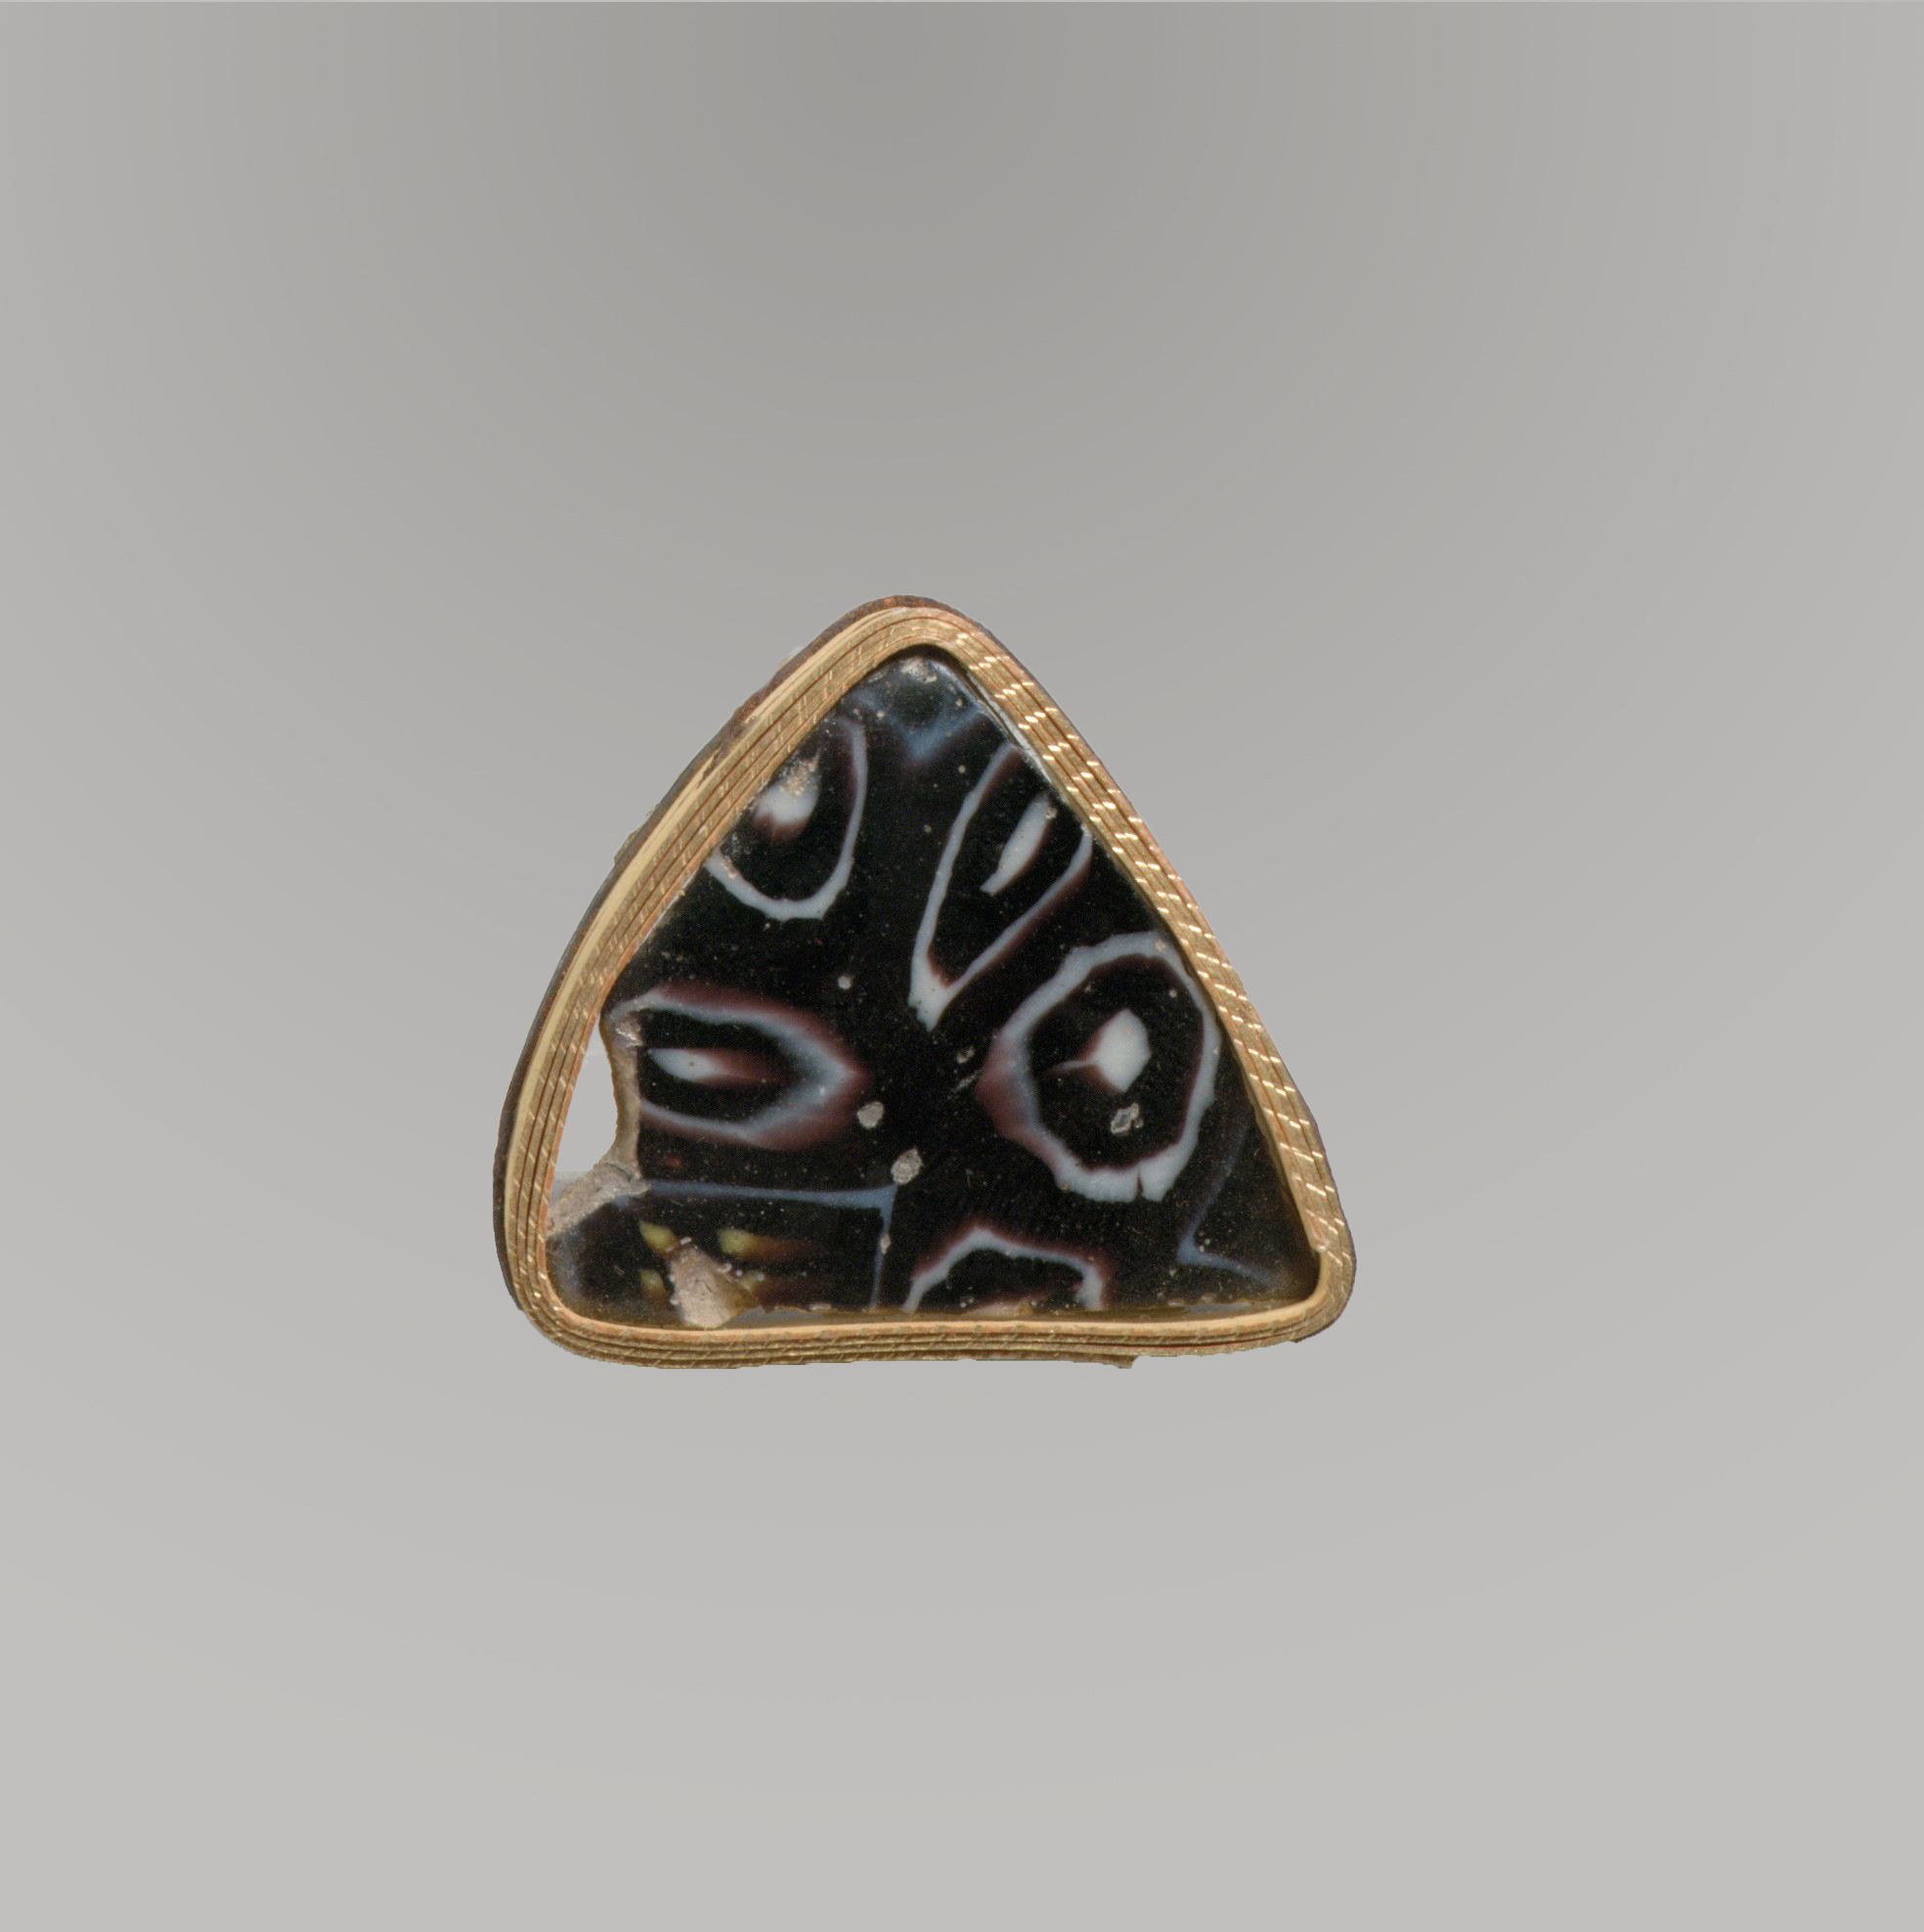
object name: fragment, mosaic bowl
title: Glass mosaic bowl fragment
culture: roman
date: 34 BCE-33 CE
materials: glass